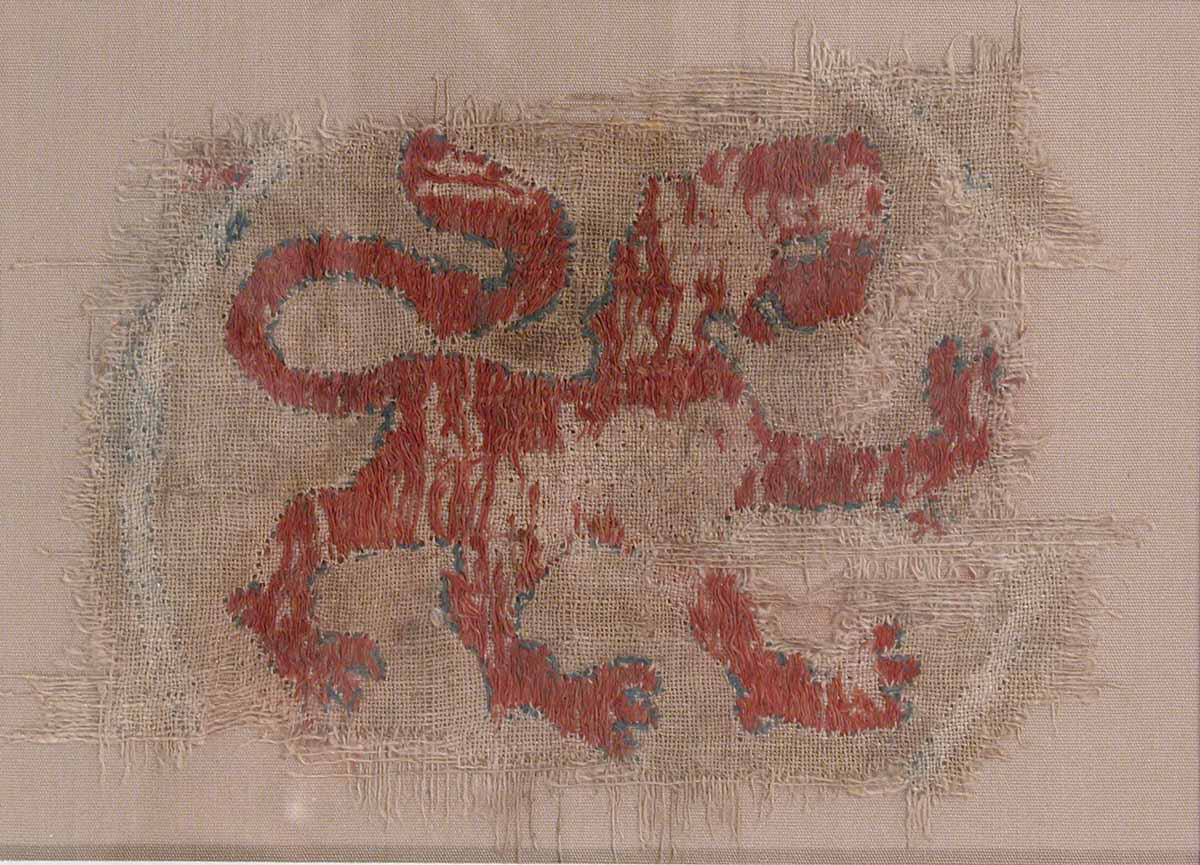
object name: blazon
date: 1251-1300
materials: linen, silk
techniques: embroidery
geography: egypt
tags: lions